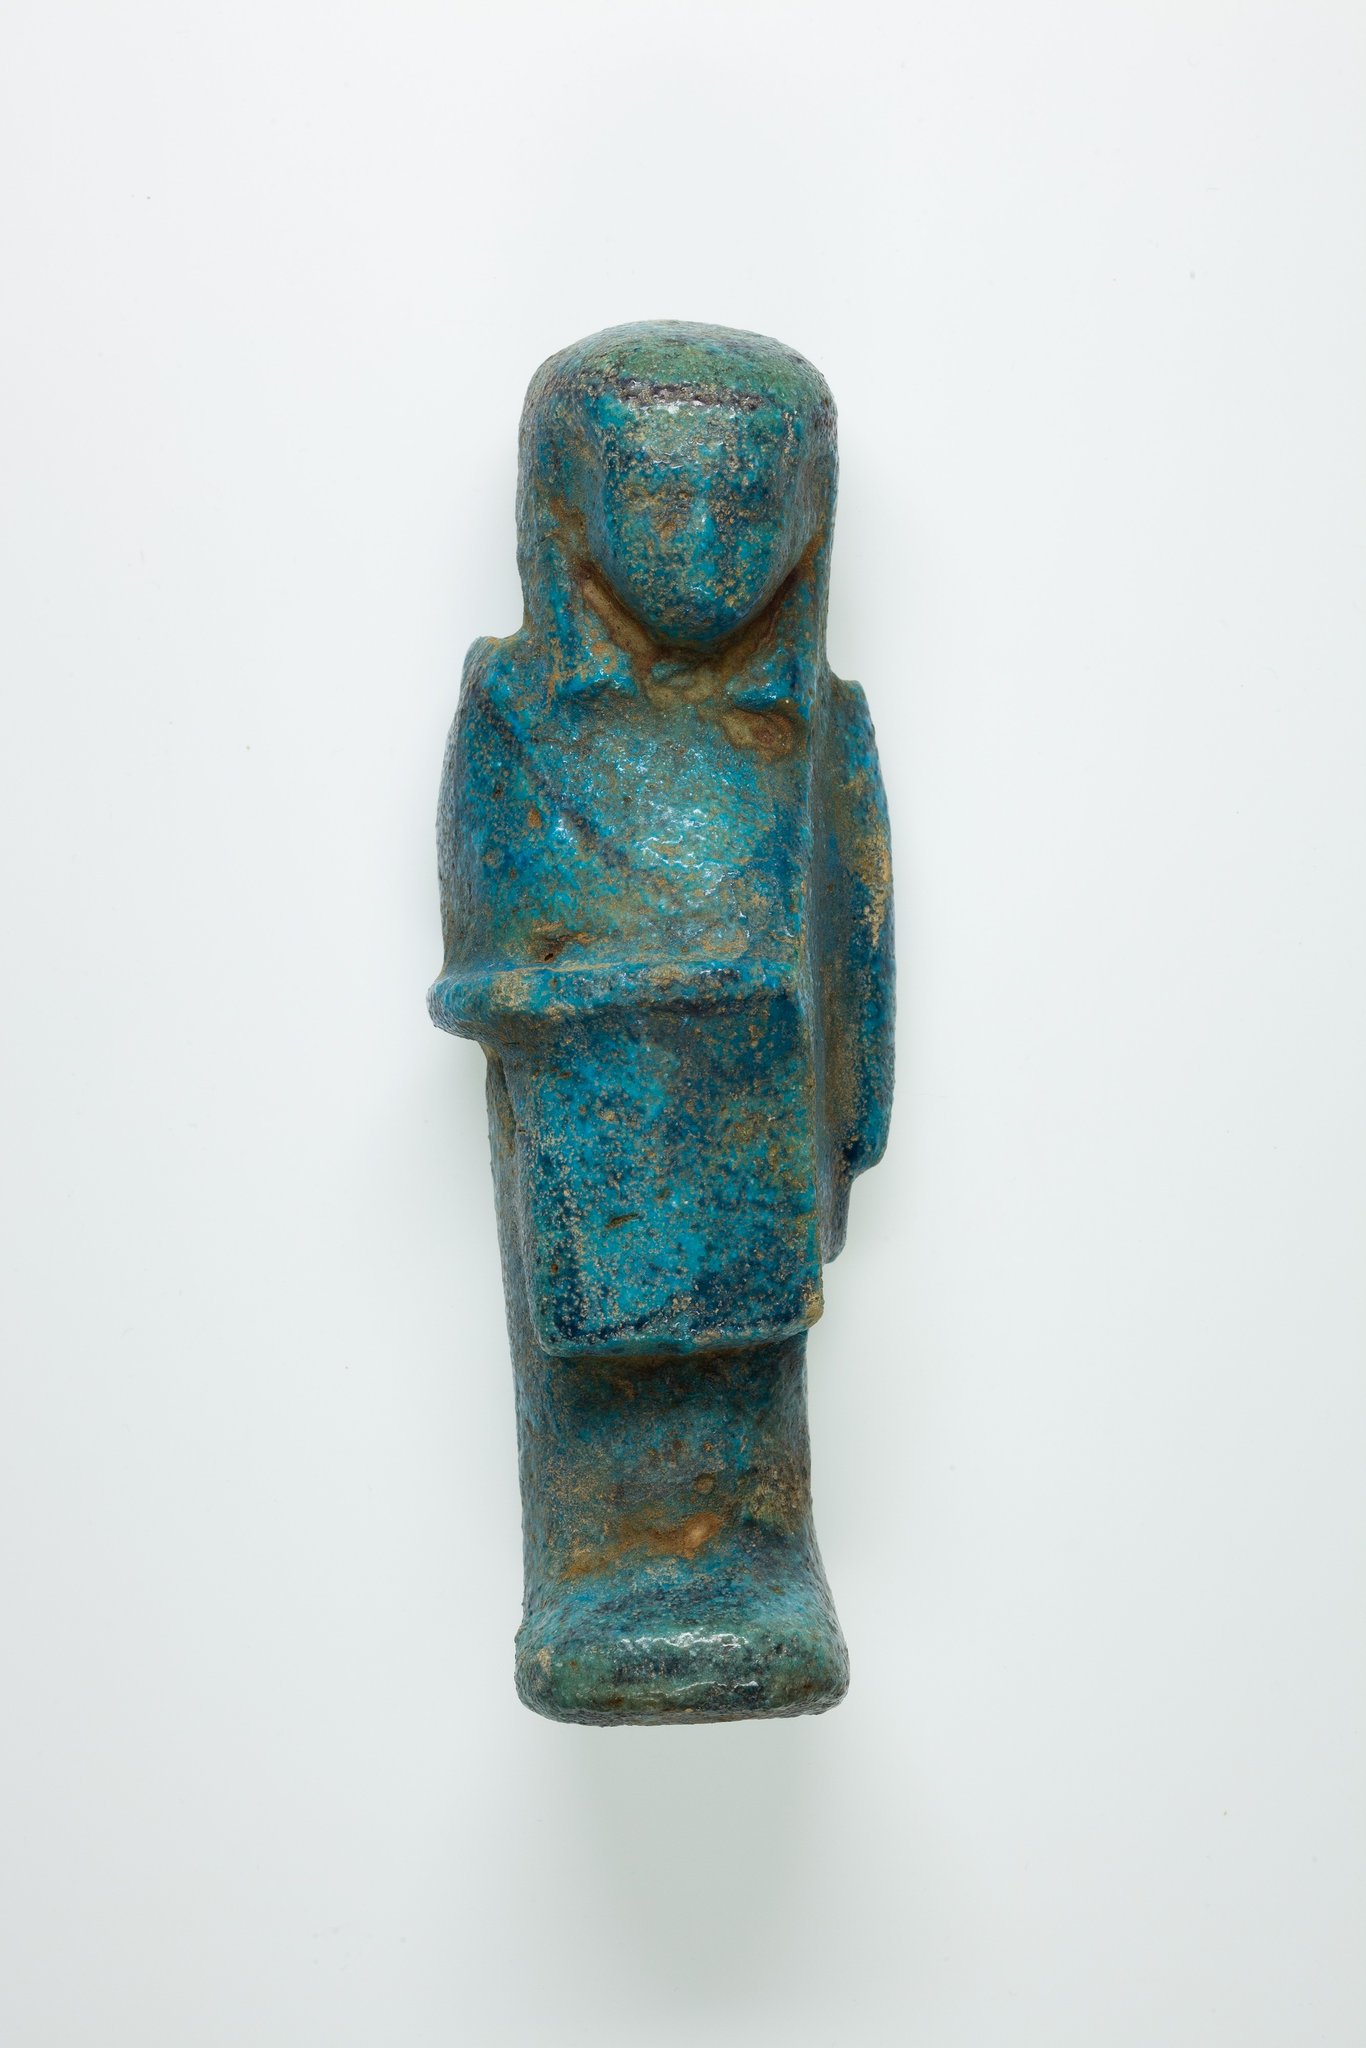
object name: overseer shabti, henettawy c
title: Overseer Shabti of Henettawy (C), Daughter of Isetemkheb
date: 990-970 BCE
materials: faience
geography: egypt